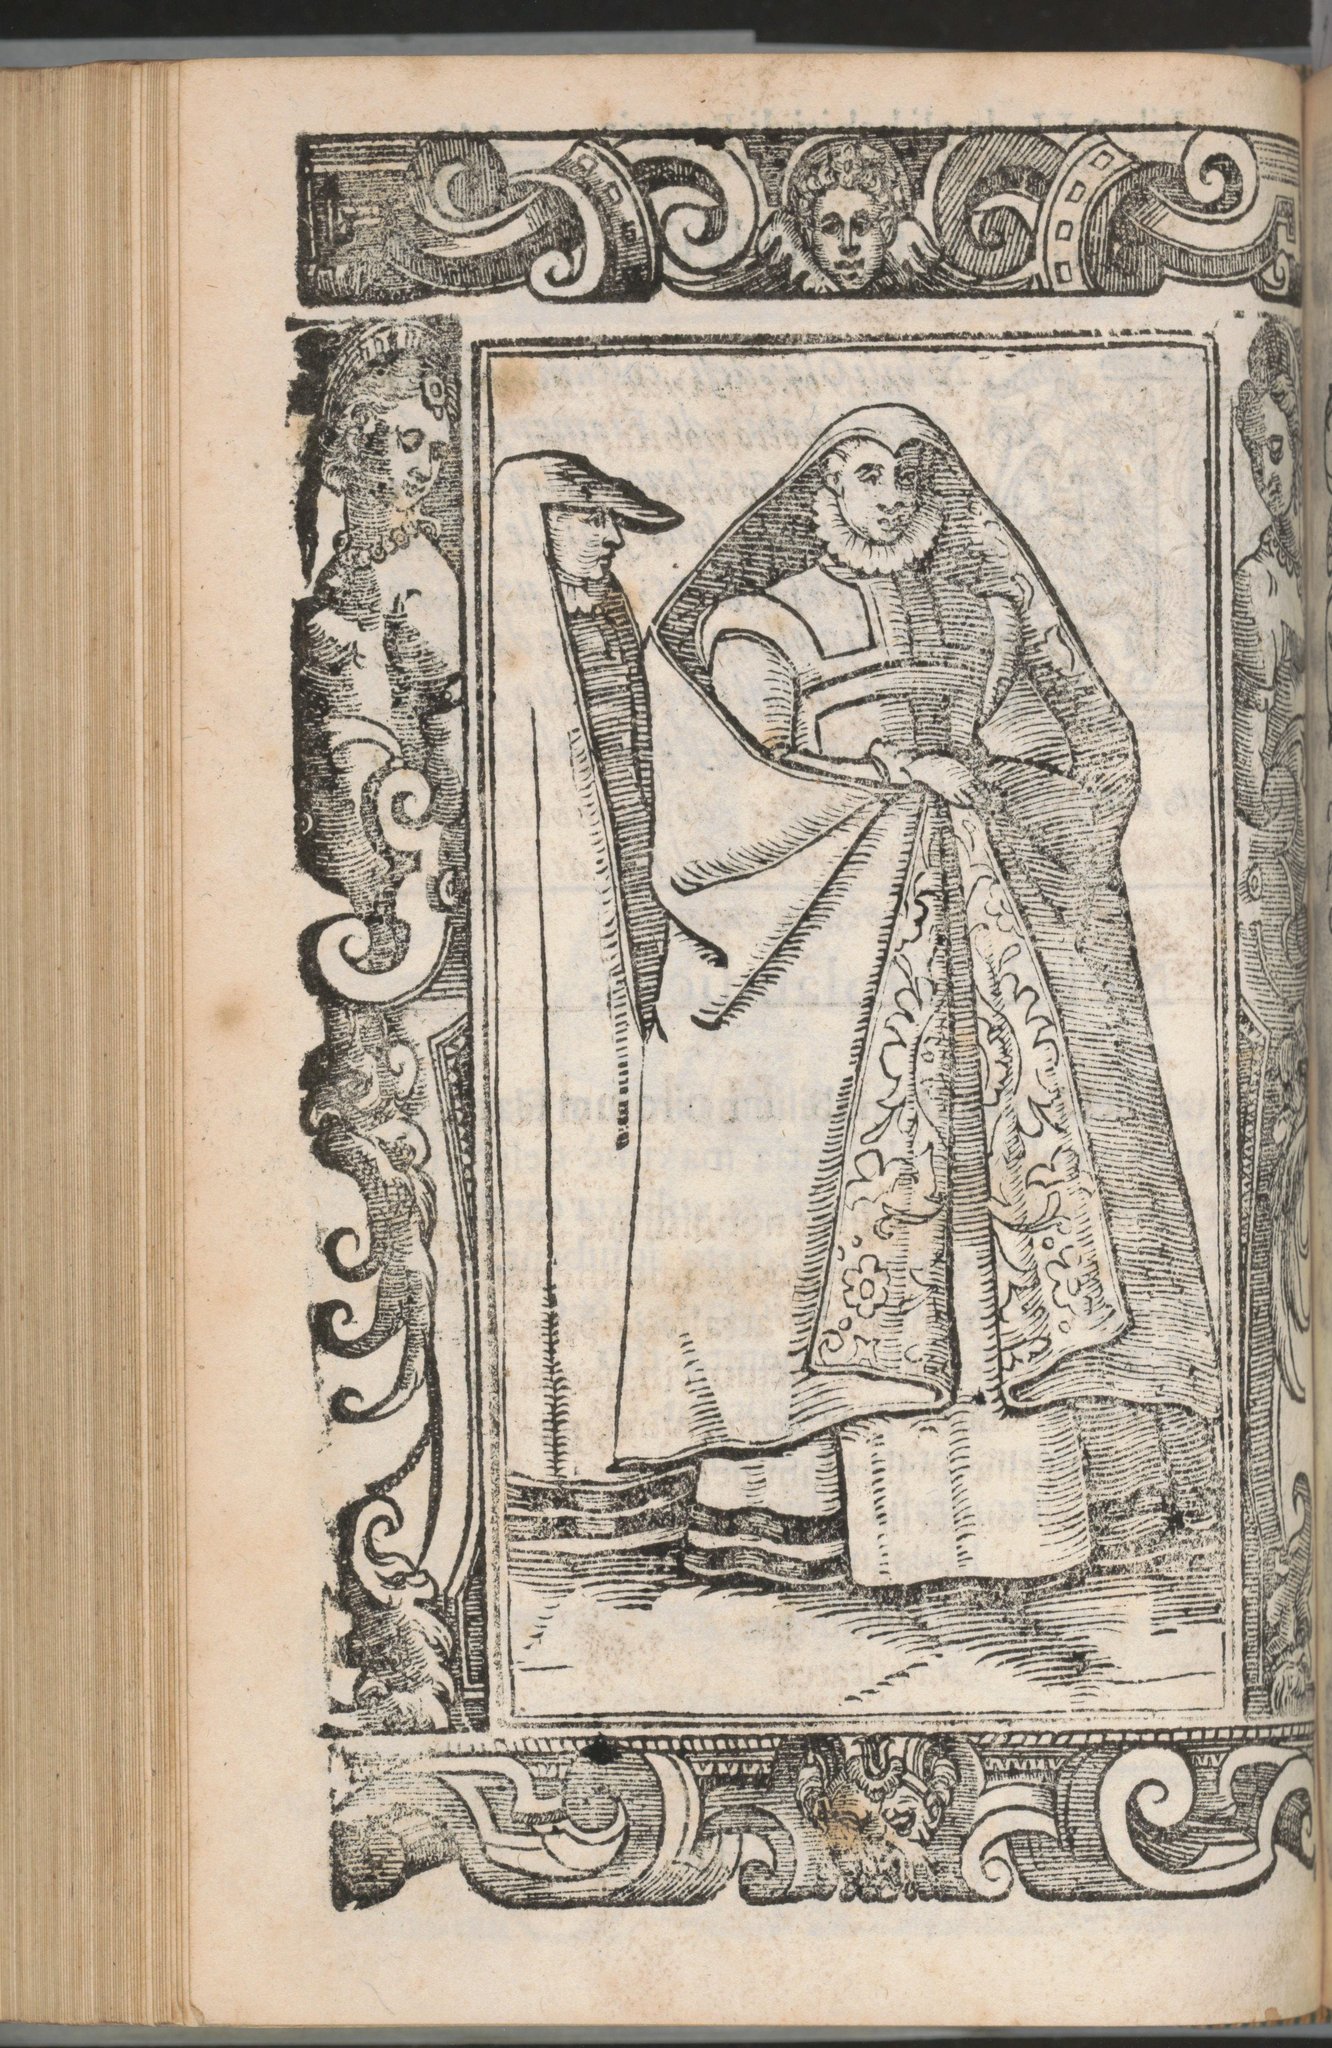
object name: costume print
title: Habiti antichi, et moderni di tutto il mondo...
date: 1598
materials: paper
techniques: woodcut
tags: fashion plates